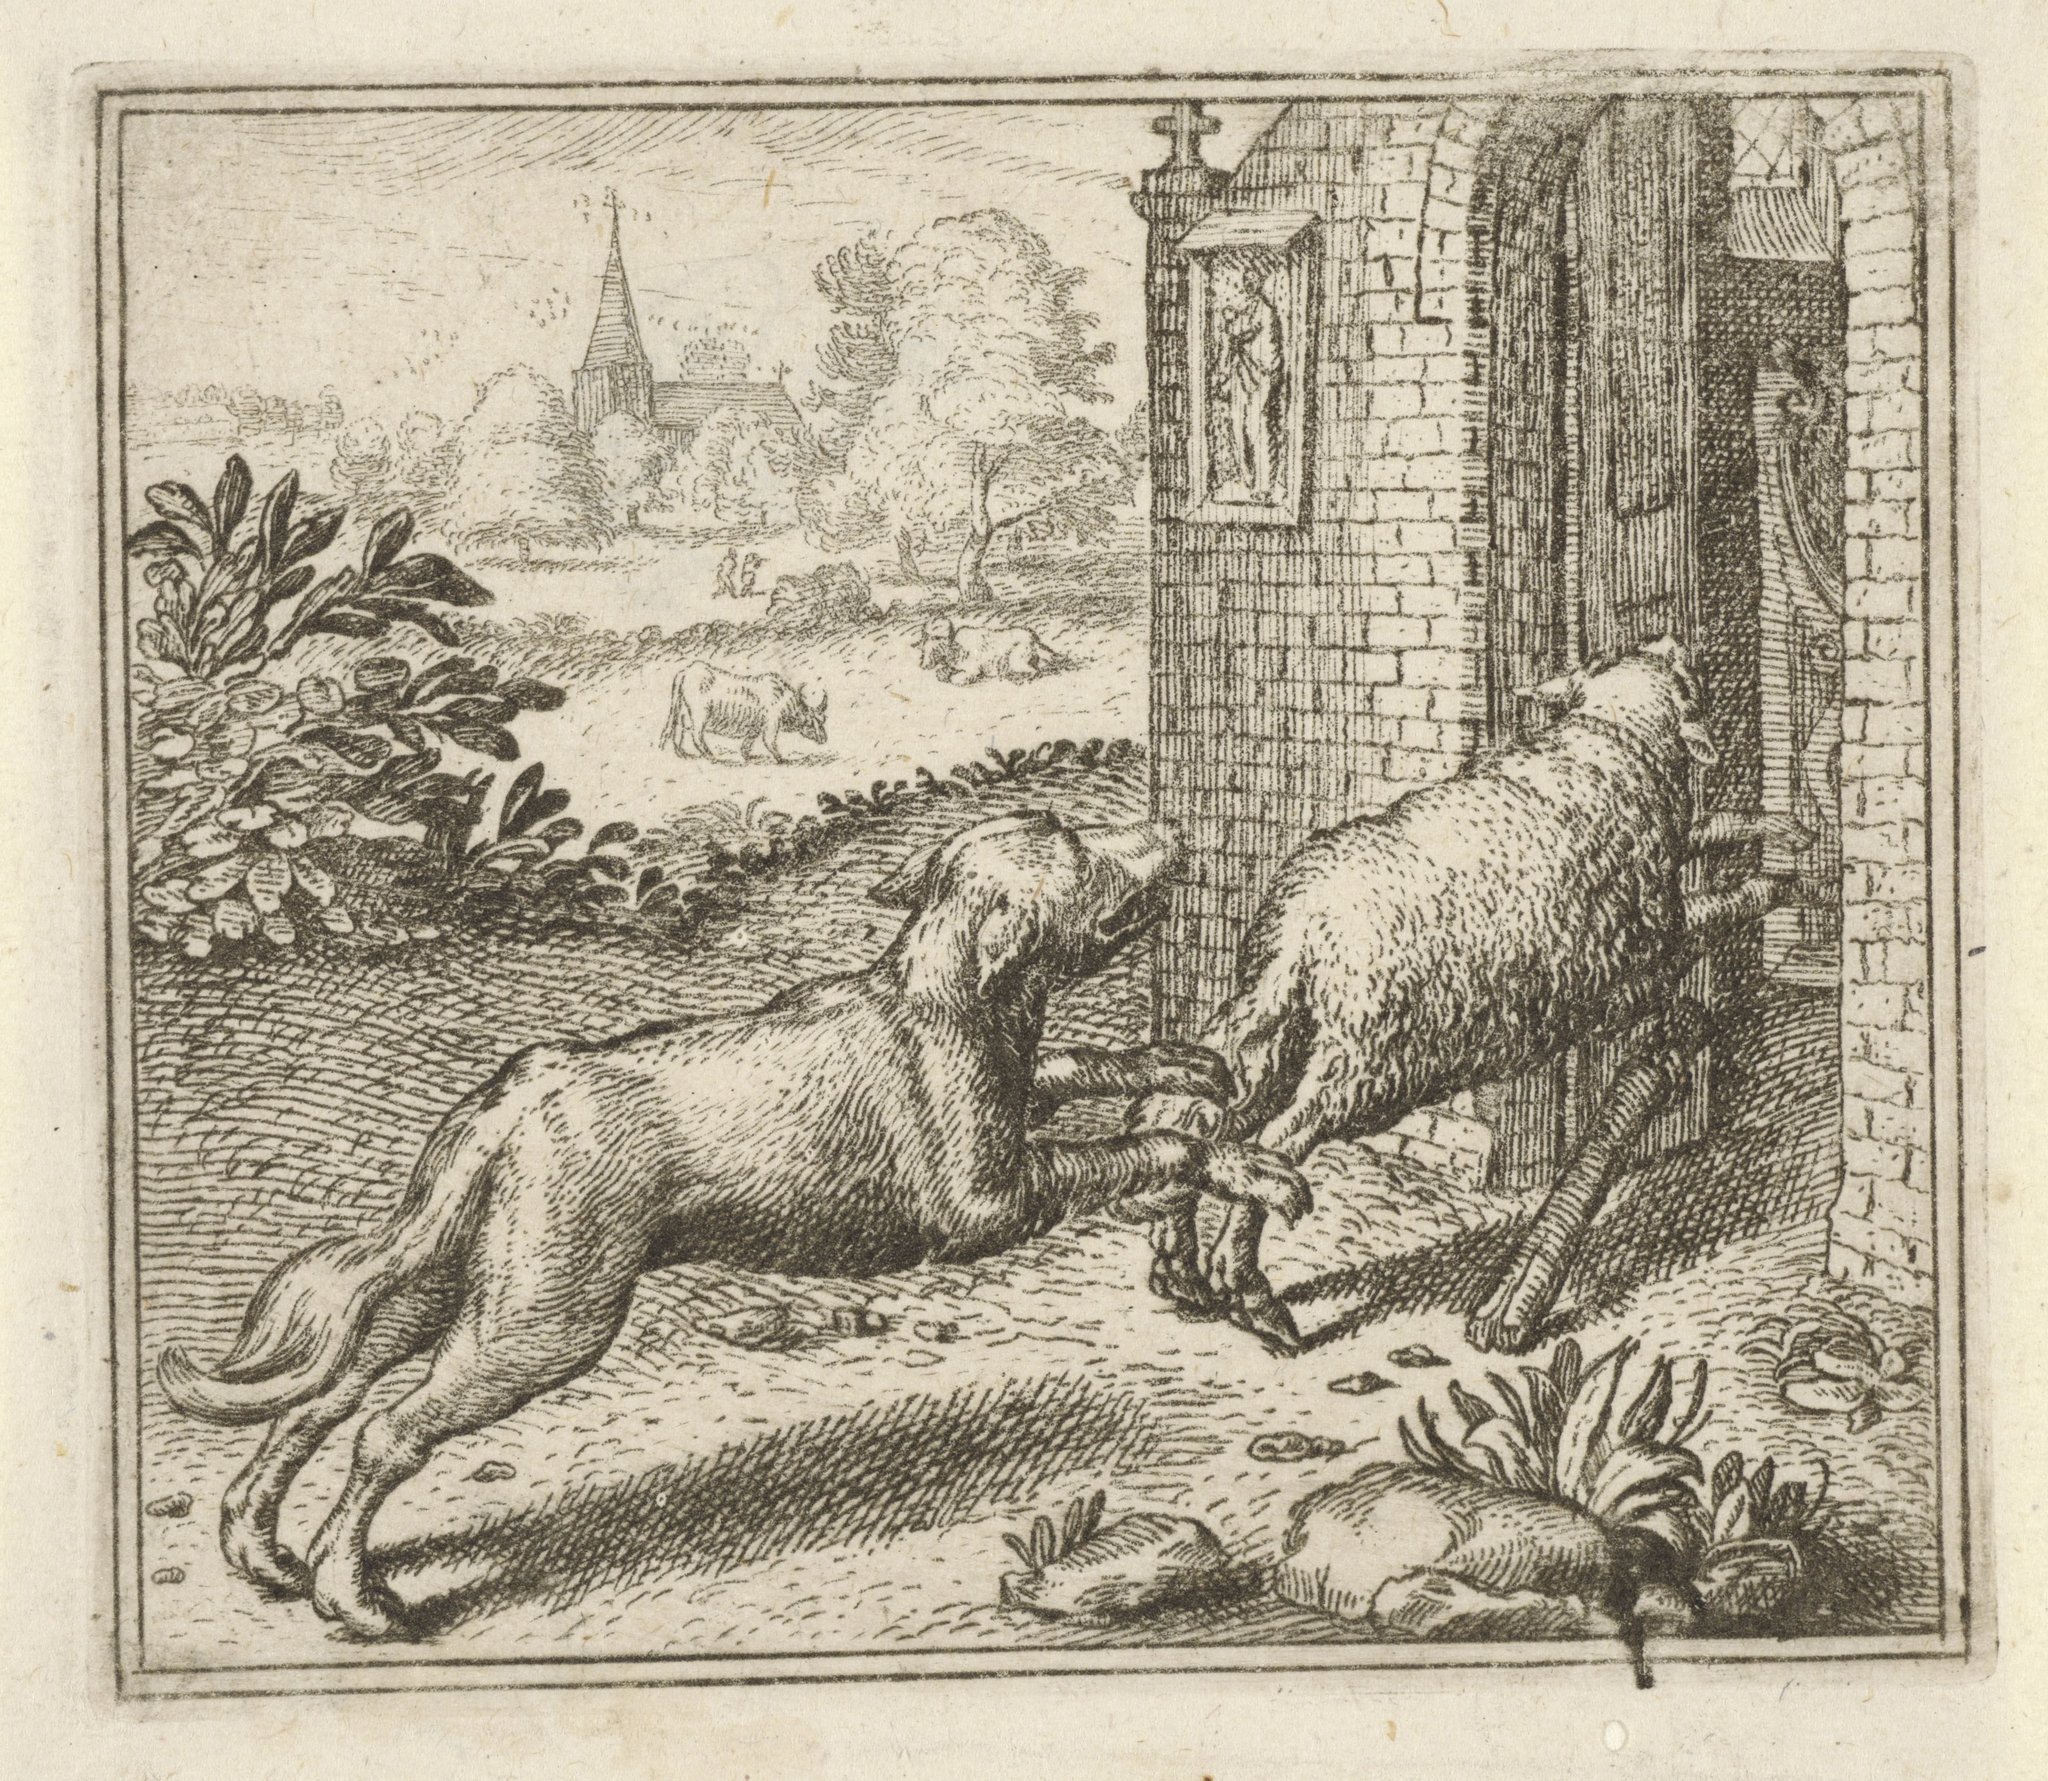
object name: print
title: Fabel van de wolf en het schaap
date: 1608-1679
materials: paper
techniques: etching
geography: prague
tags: sheep, fables, church (exterior) - qq - small church, chapel, beasts of prey, predatory animals: wolf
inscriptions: collector's mark: Lugt 2228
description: Een schaap rent een kerk binnen, gevolgd door een wolf. De fabel beschrijft hoe een wolf een schaap achtervolgt en opgesloten wordt in een kerk. De moraal van het verhaal leert dat men beter zijn lusten kan bedwingen.